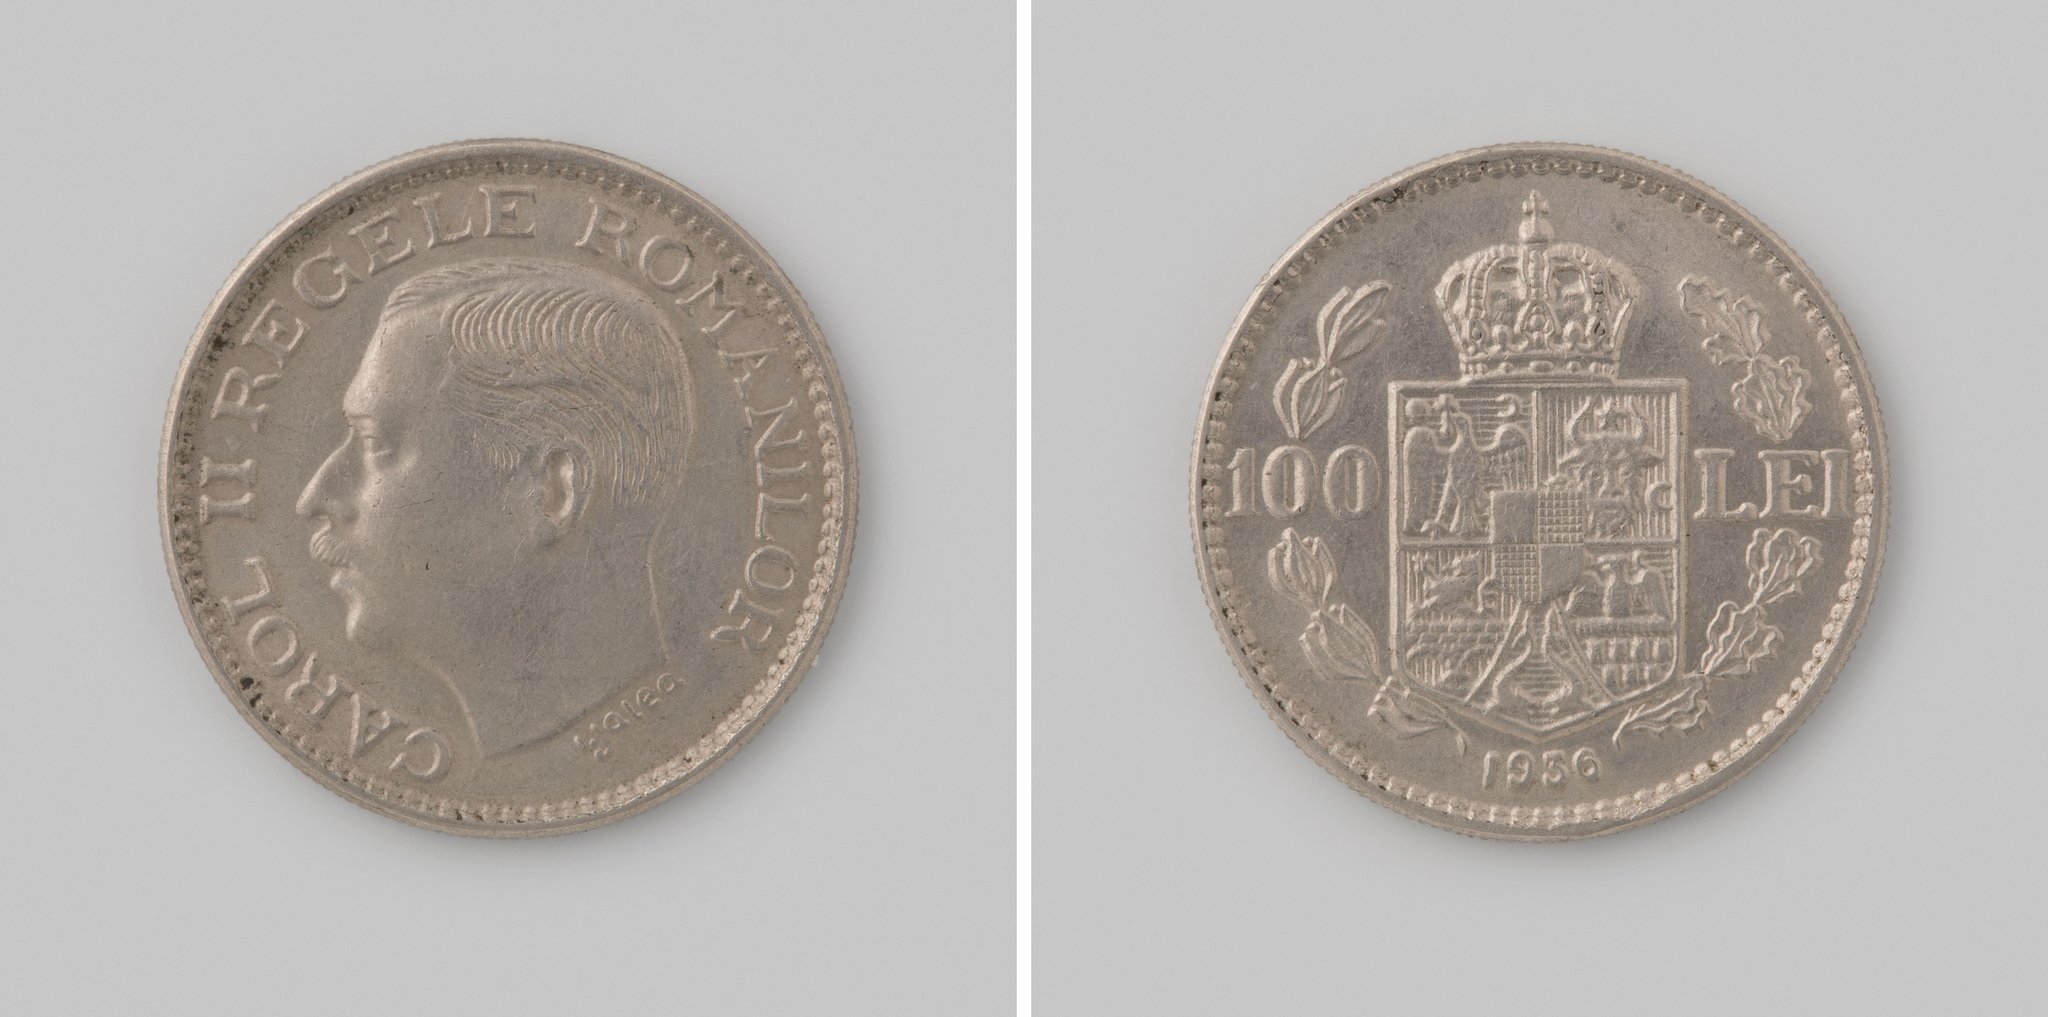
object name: coin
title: Roemenië, koning Carol II, 100 lei, 1936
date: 1936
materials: nickel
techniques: striking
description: Nikkelen munt. Voorzijde: hoofd van de koning naar links. Keerzijde: binnen twee takken tussen waarde-aanduiding gekroond wapenschild. Jaartal onderaan. Kartelrand.